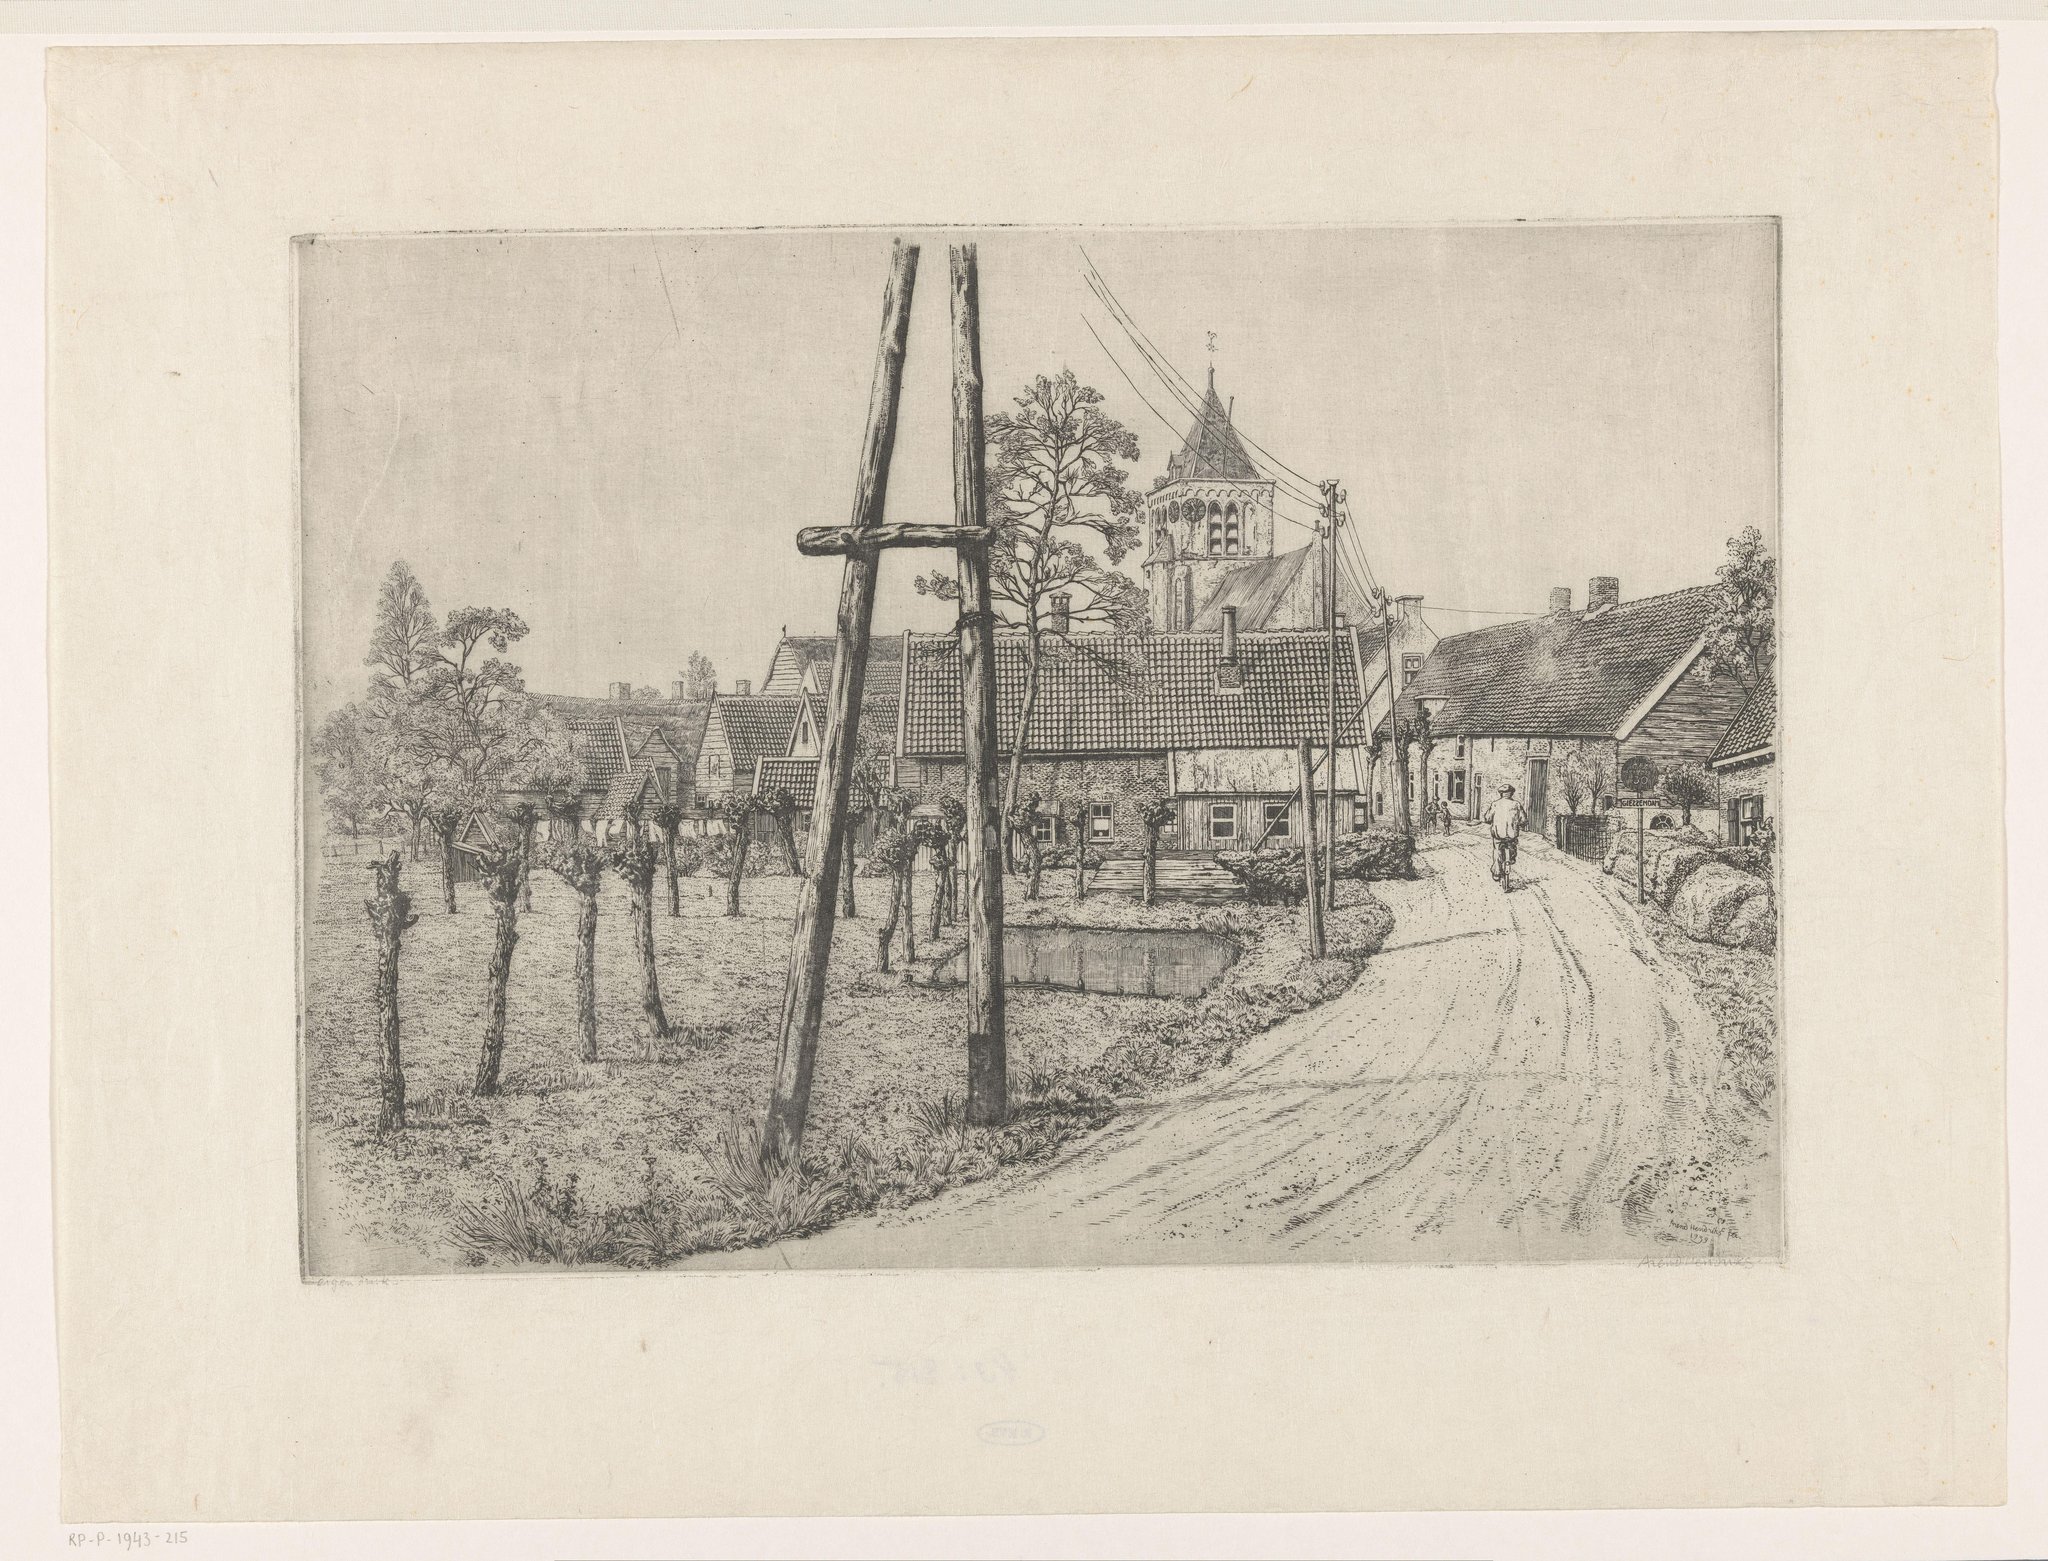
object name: print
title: Boomgaard bij Giessendam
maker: arend hendriks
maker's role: print maker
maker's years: 1901-1951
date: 1939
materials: paper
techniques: etching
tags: village, orchard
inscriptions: collector's mark: Lugt 2228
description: Een boomgaard met geknotte bomen. Een fietser rijdt het dorp Giessendam binnen. Op de achtergrond een kerktoren.